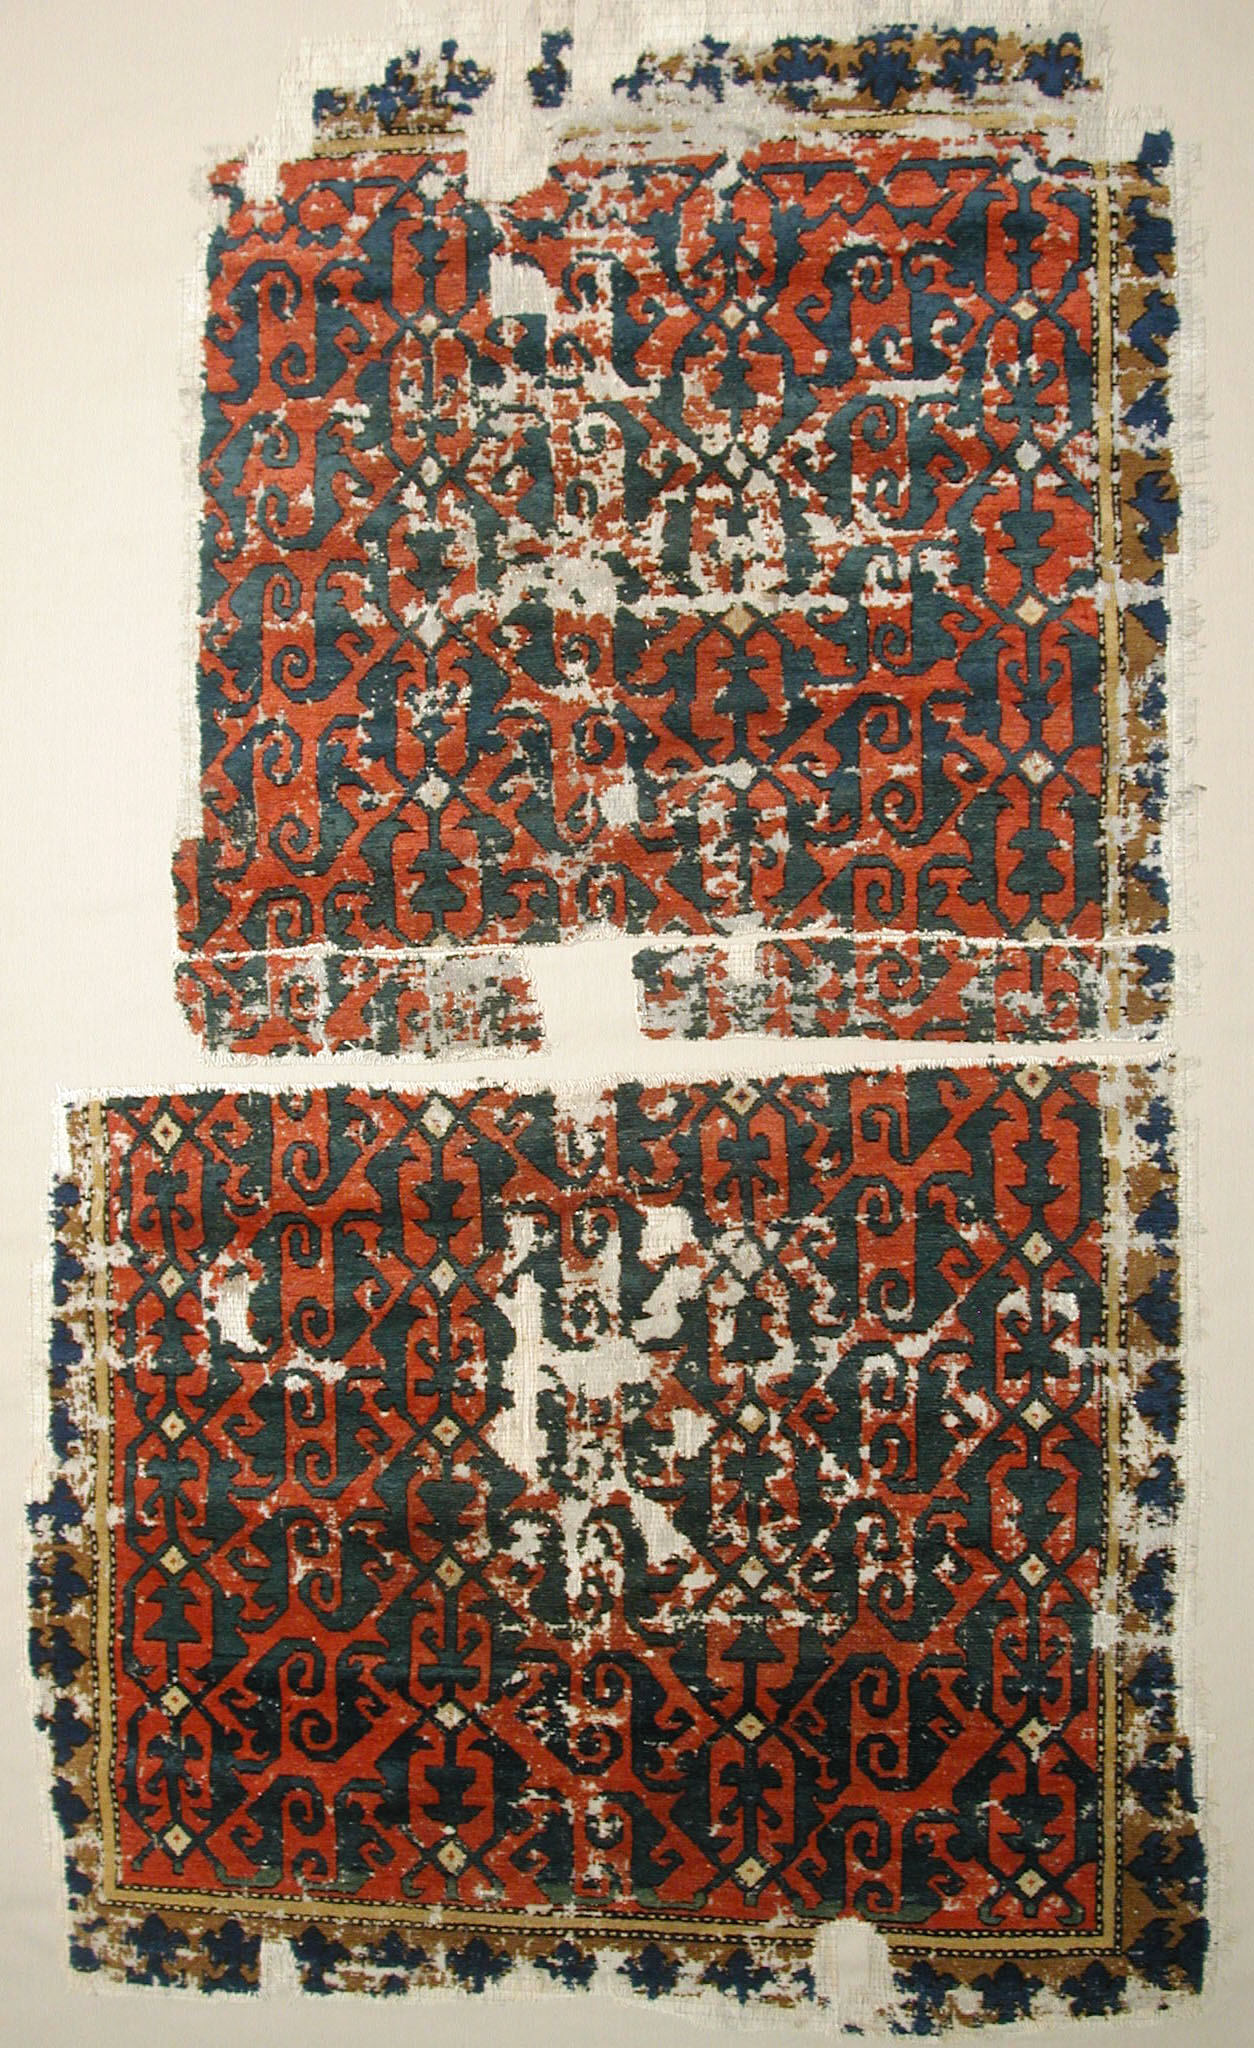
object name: carpet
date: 1701-1800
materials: cotton, wool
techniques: pile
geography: azerbaijan